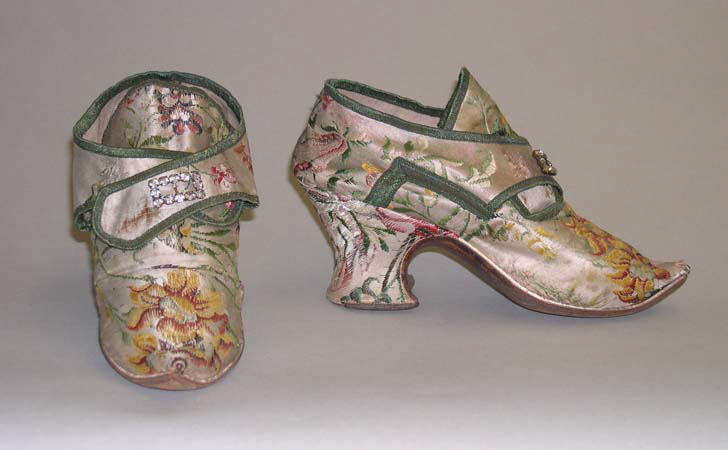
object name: shoe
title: Shoes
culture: british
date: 1701-1733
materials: silk